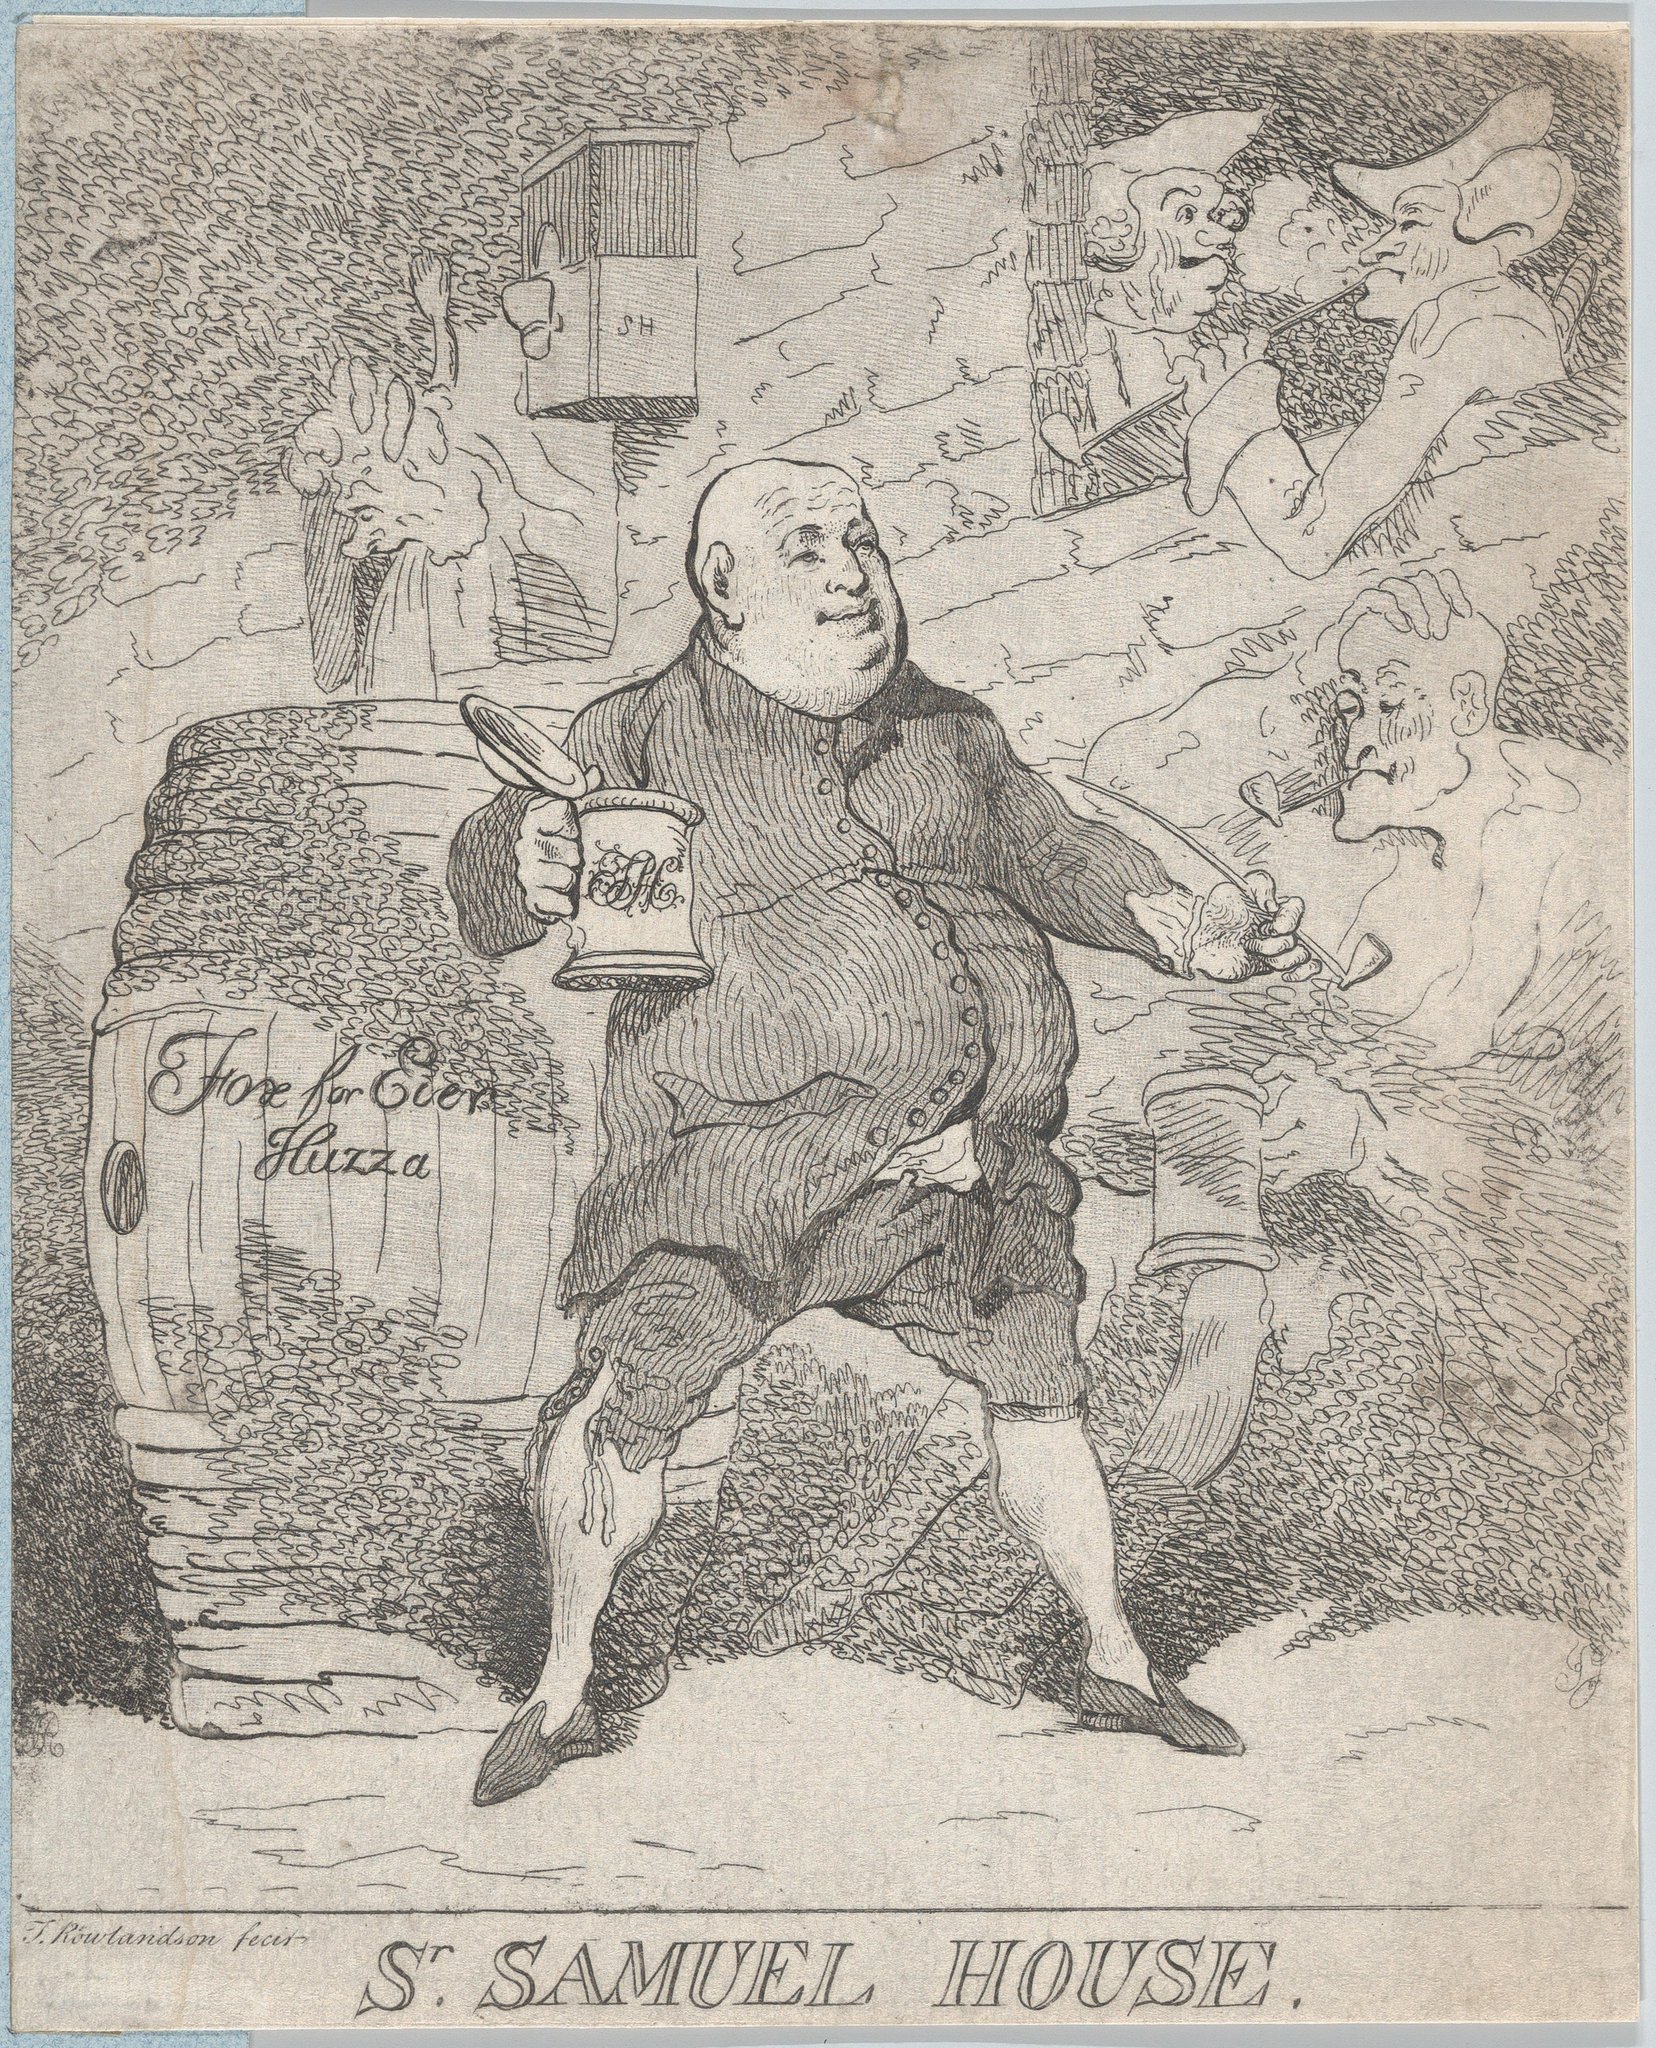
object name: print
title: Sr. Samuel House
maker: thomas rowlandson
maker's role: artist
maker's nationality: british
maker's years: 1757-1827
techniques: etching, roulette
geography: london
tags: satire,men,drinking